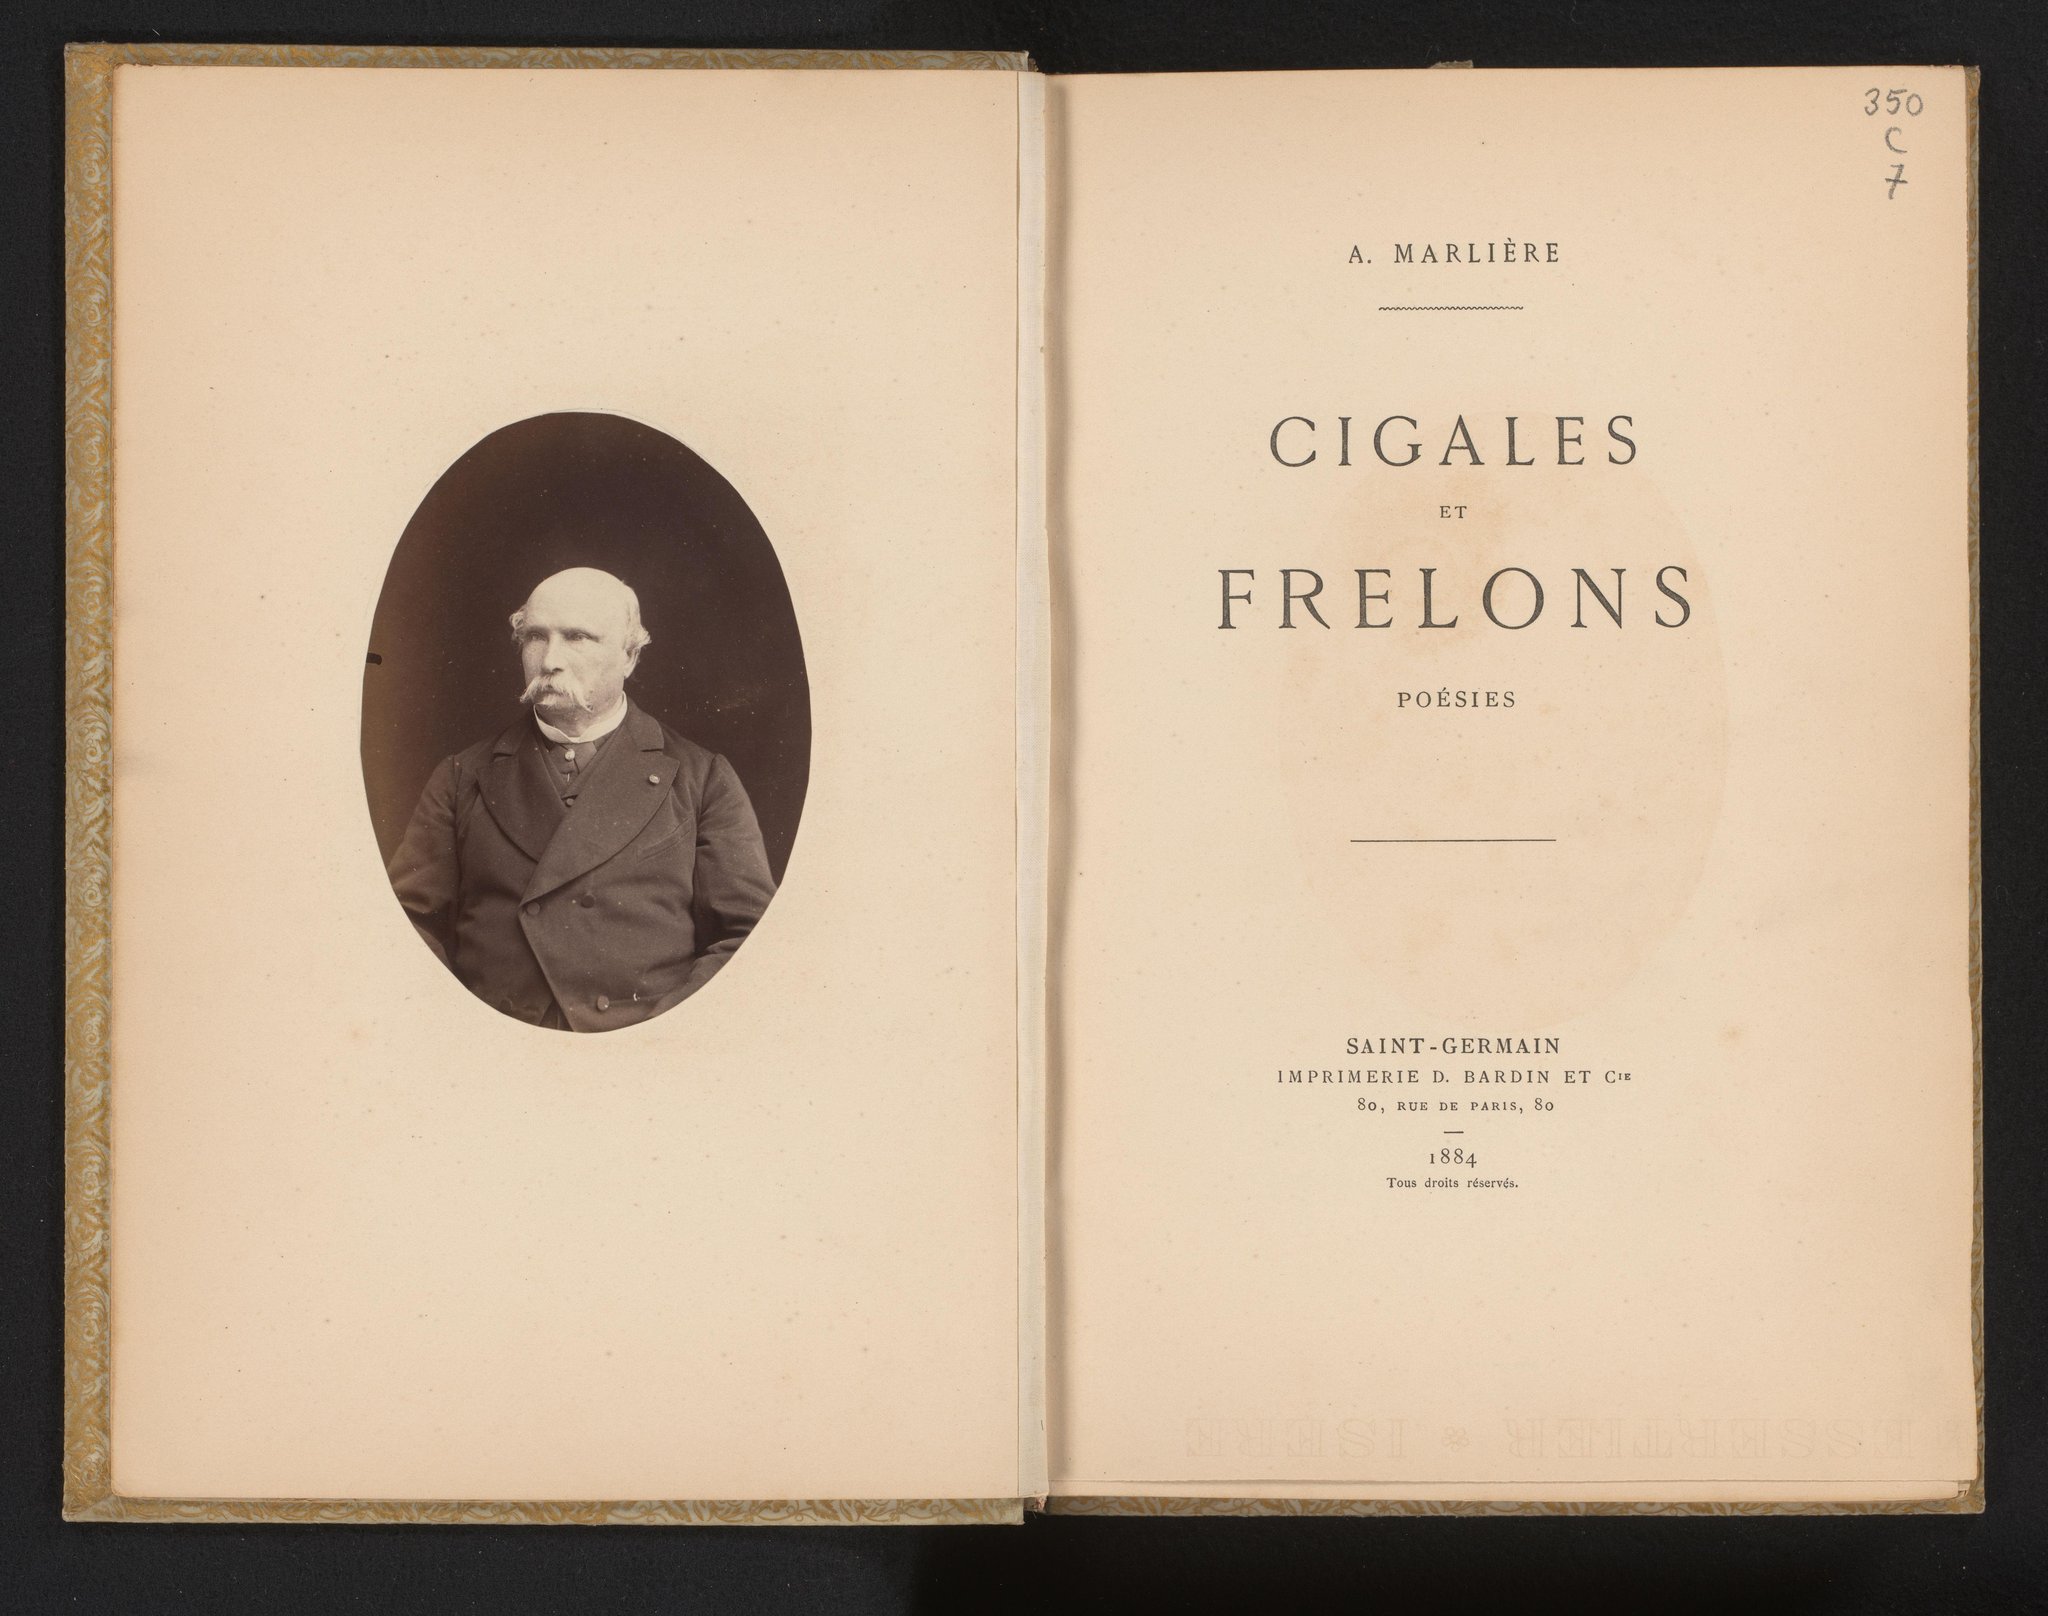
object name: book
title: Cigales et frelons: poésies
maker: a. marlière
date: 1884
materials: cardboard, leather, paper, parchment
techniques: albumen print, letterpress printing, marbled paper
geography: saint-germain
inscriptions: inscription: ‘a mon excellent ami/’